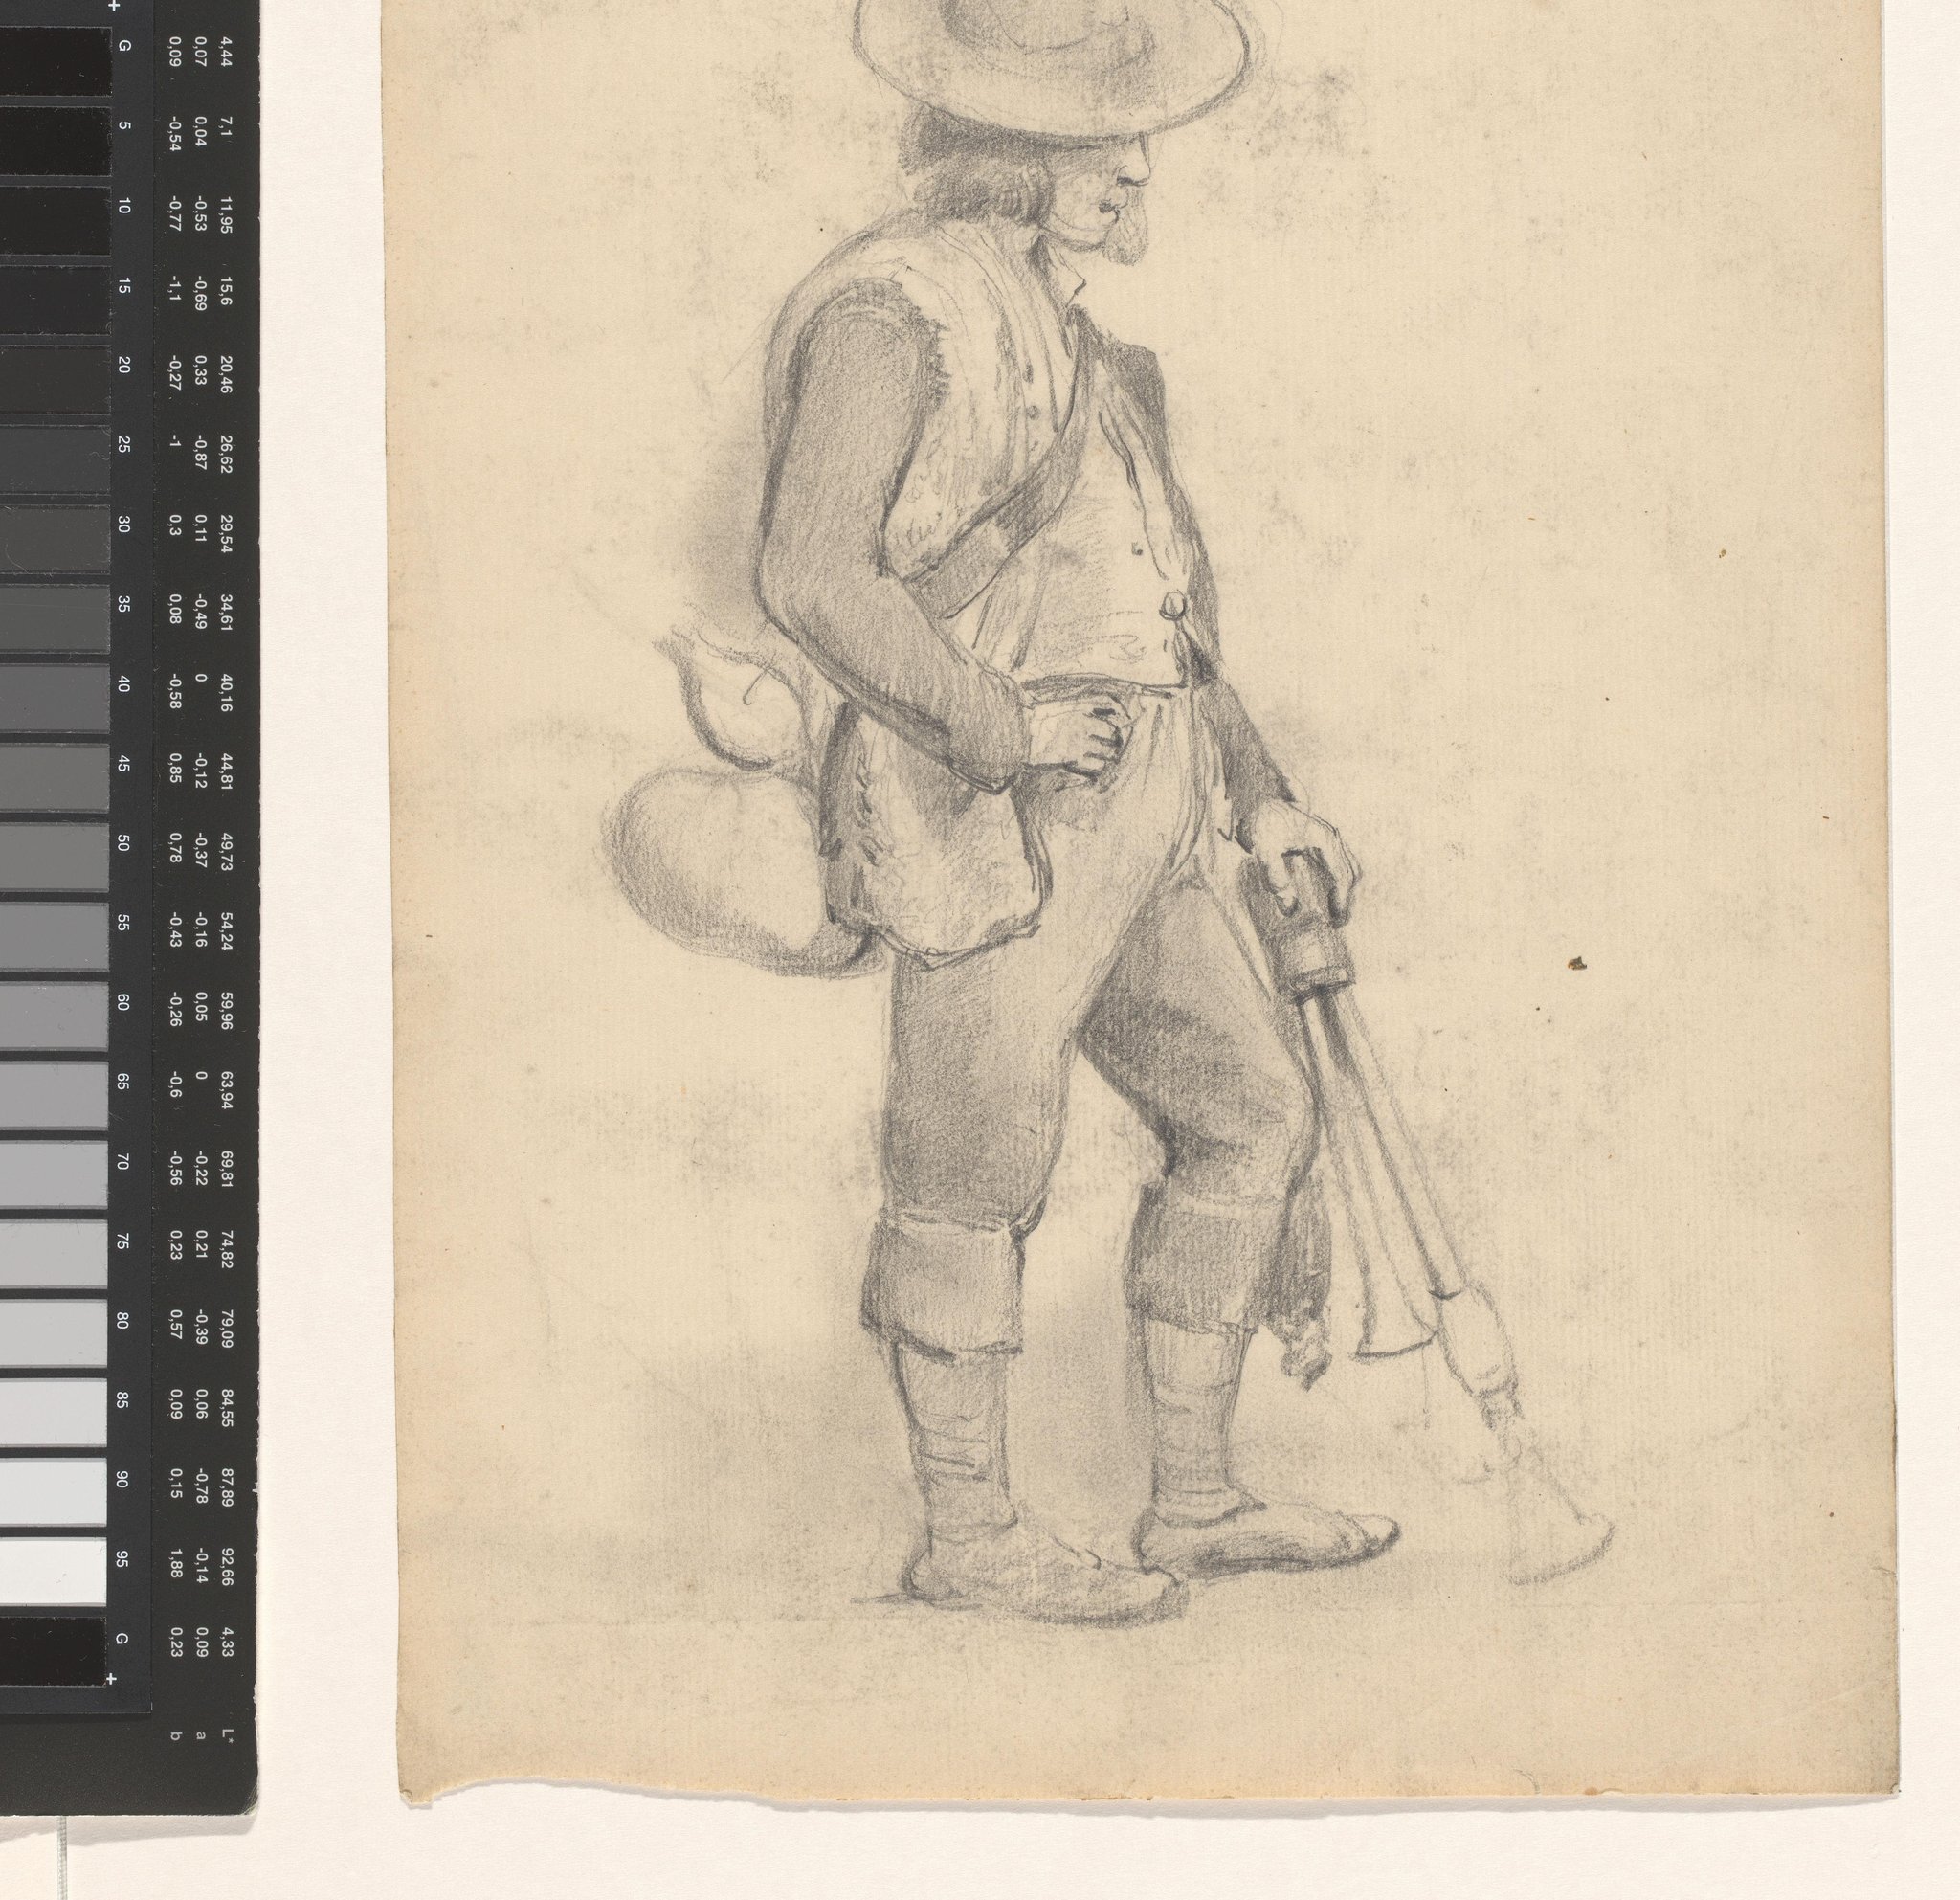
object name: drawing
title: Staande man met hoed en blaasinstrument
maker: jan bedijs tom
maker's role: draughtsman, painter, print maker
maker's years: 1813-1894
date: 1823-1894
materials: paper, pencil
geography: the hague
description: Staande man met hoed, de linkerarm steundend op een blaasinstrument